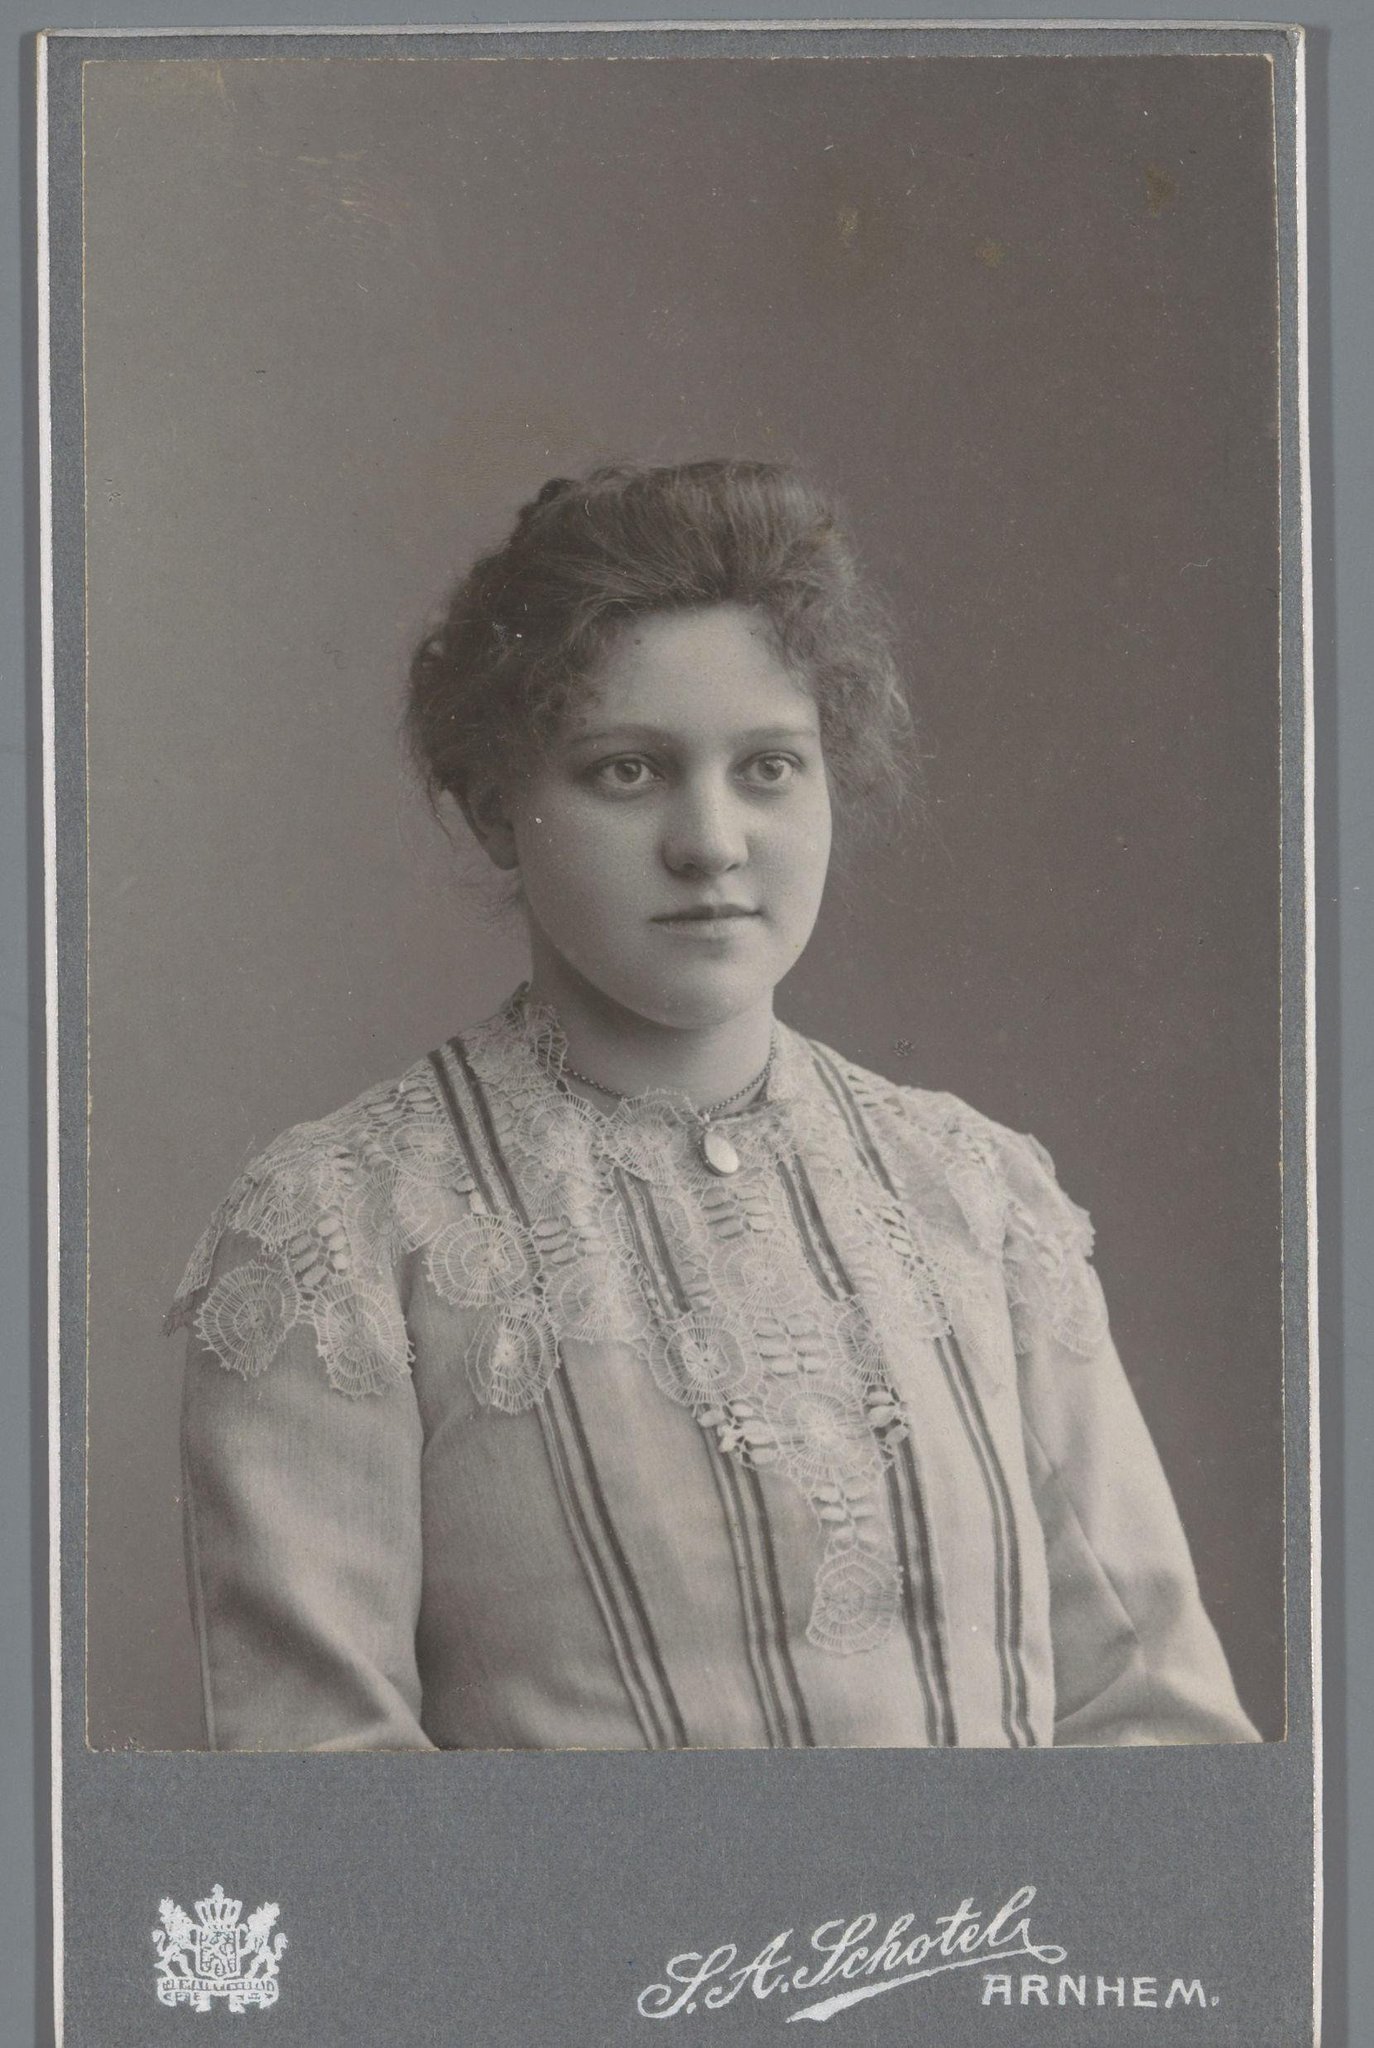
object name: carte de visite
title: Portret van Louise Honing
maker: stephanus adrianus schotel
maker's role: fotograaf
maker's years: 1871-1957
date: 1905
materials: paper, cardboard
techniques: gelatin silver print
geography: arnhem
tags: adolescent, young woman, maiden, historical persons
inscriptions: address: ‘Velperbuitensingel 10/ ARNEM’, inscription: ‘PLATEN BLIJVEN/ VOOR NABESTELLING BEWAARD/ Prager & Lojda, Berlin/ 25604’